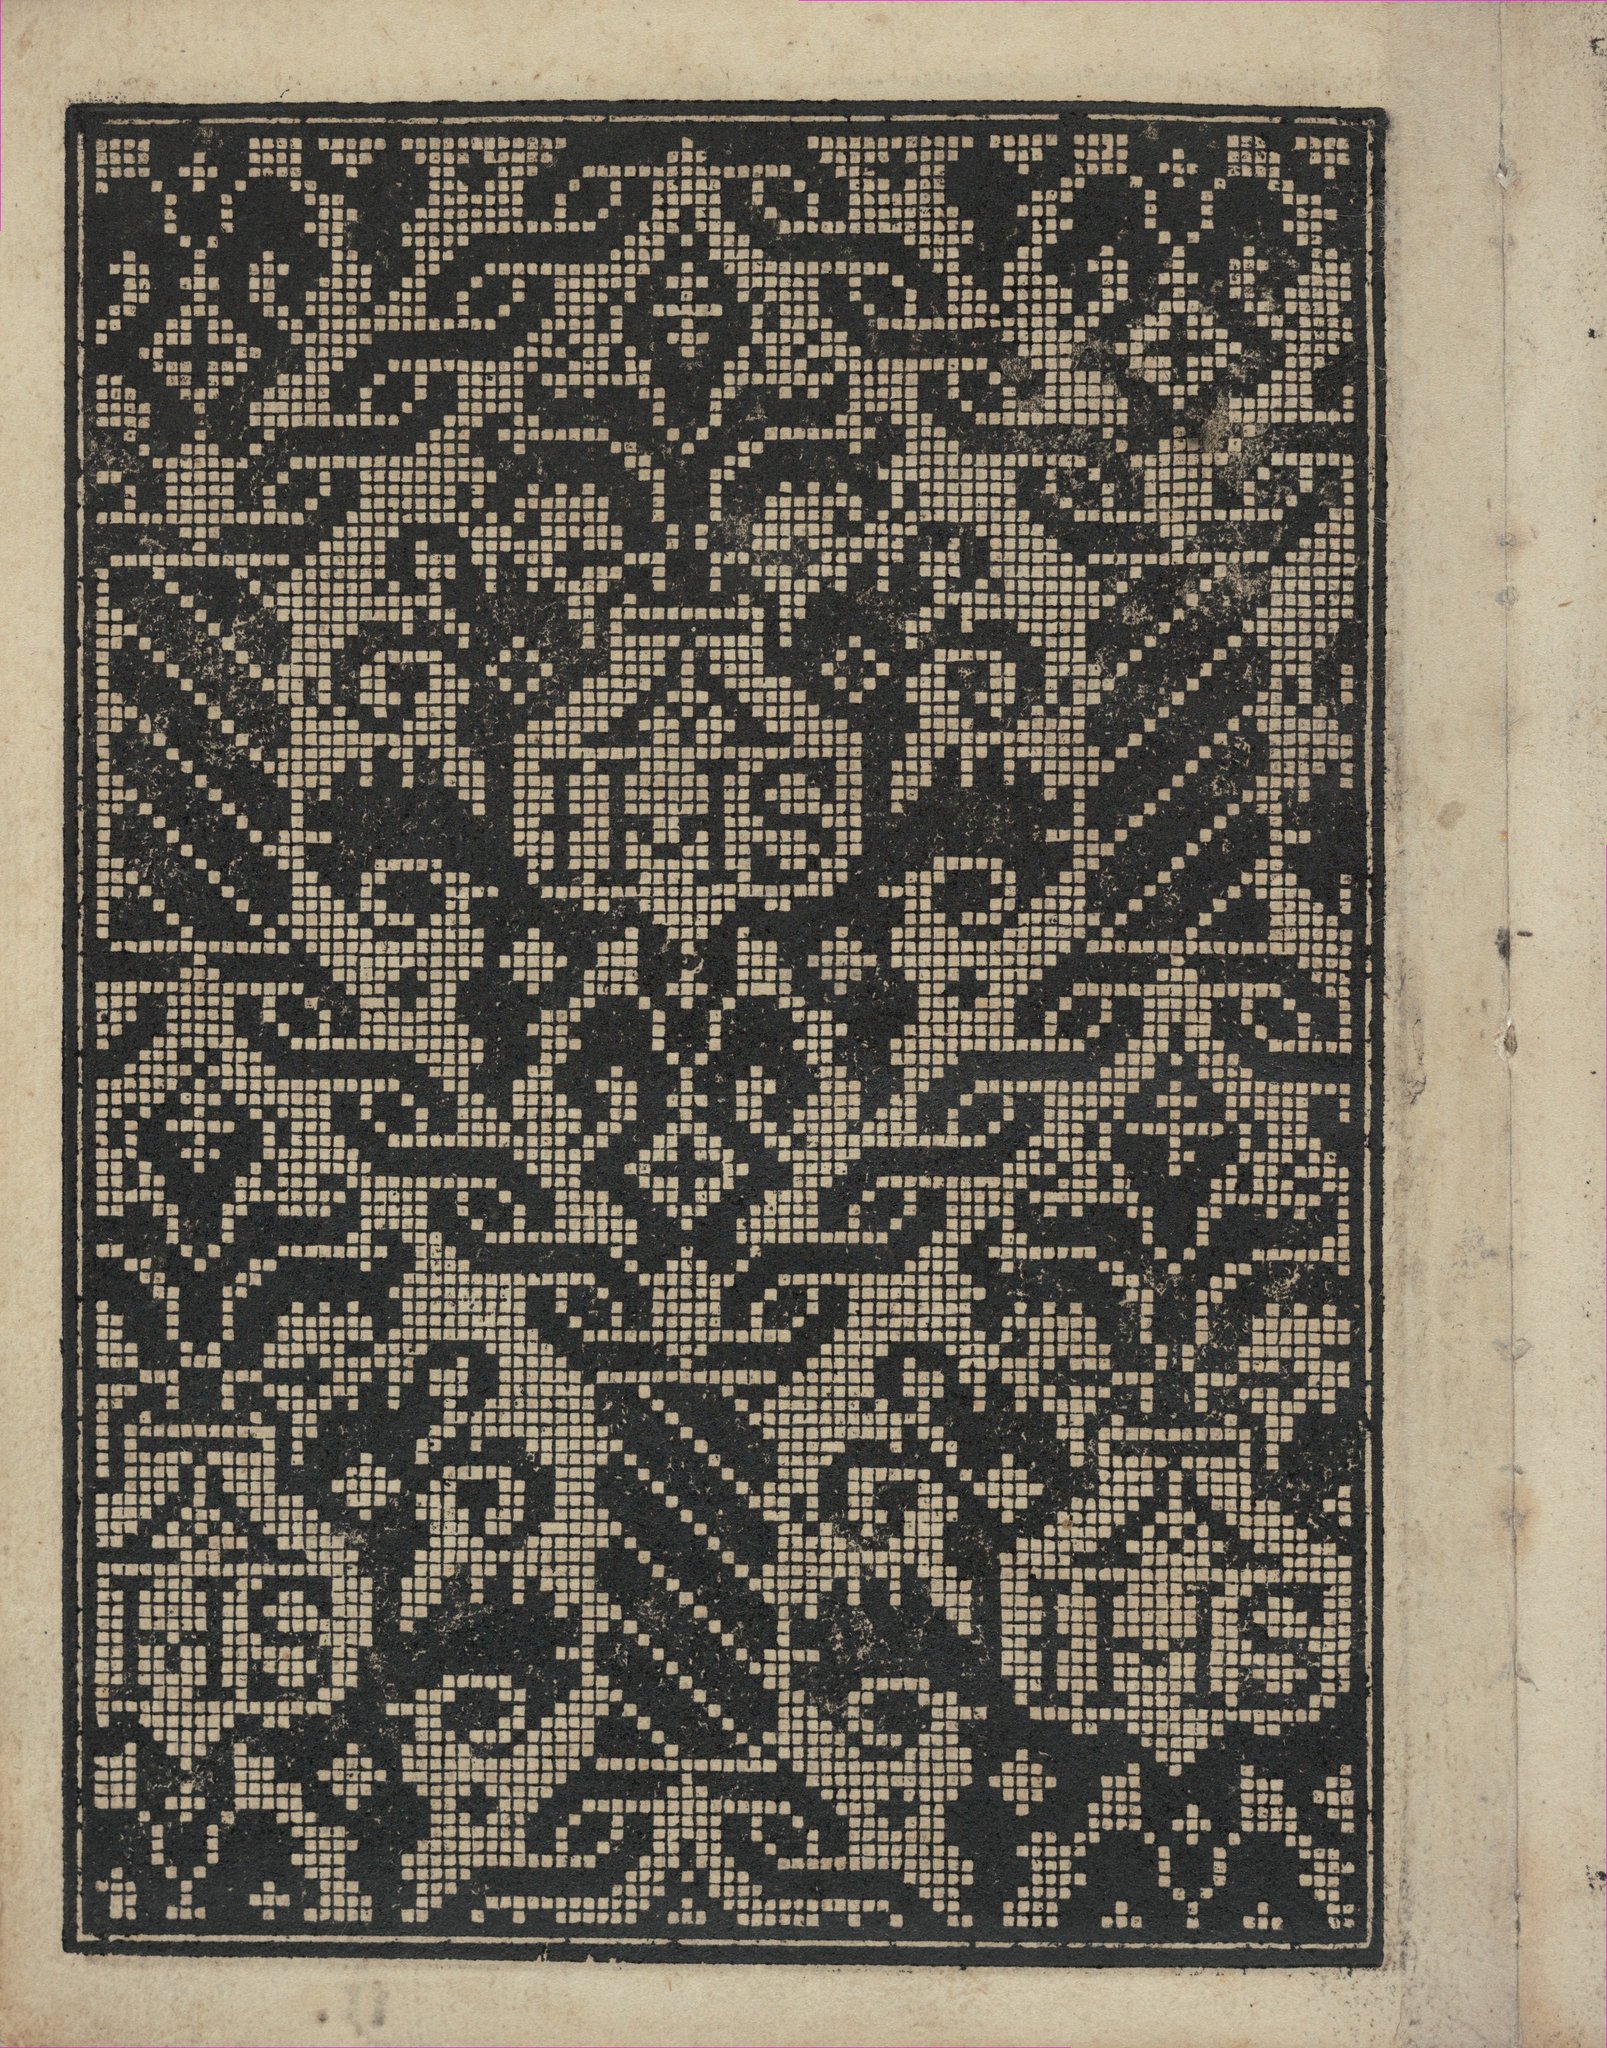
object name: book print ornament architecture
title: Libbretto nouellamete composto per maestro Domenico da Sera...lauorare di ogni sorte di punti, page 9 (verso)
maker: domenico da sera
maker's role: publisher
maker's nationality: french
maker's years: 1500-1599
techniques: woodcut